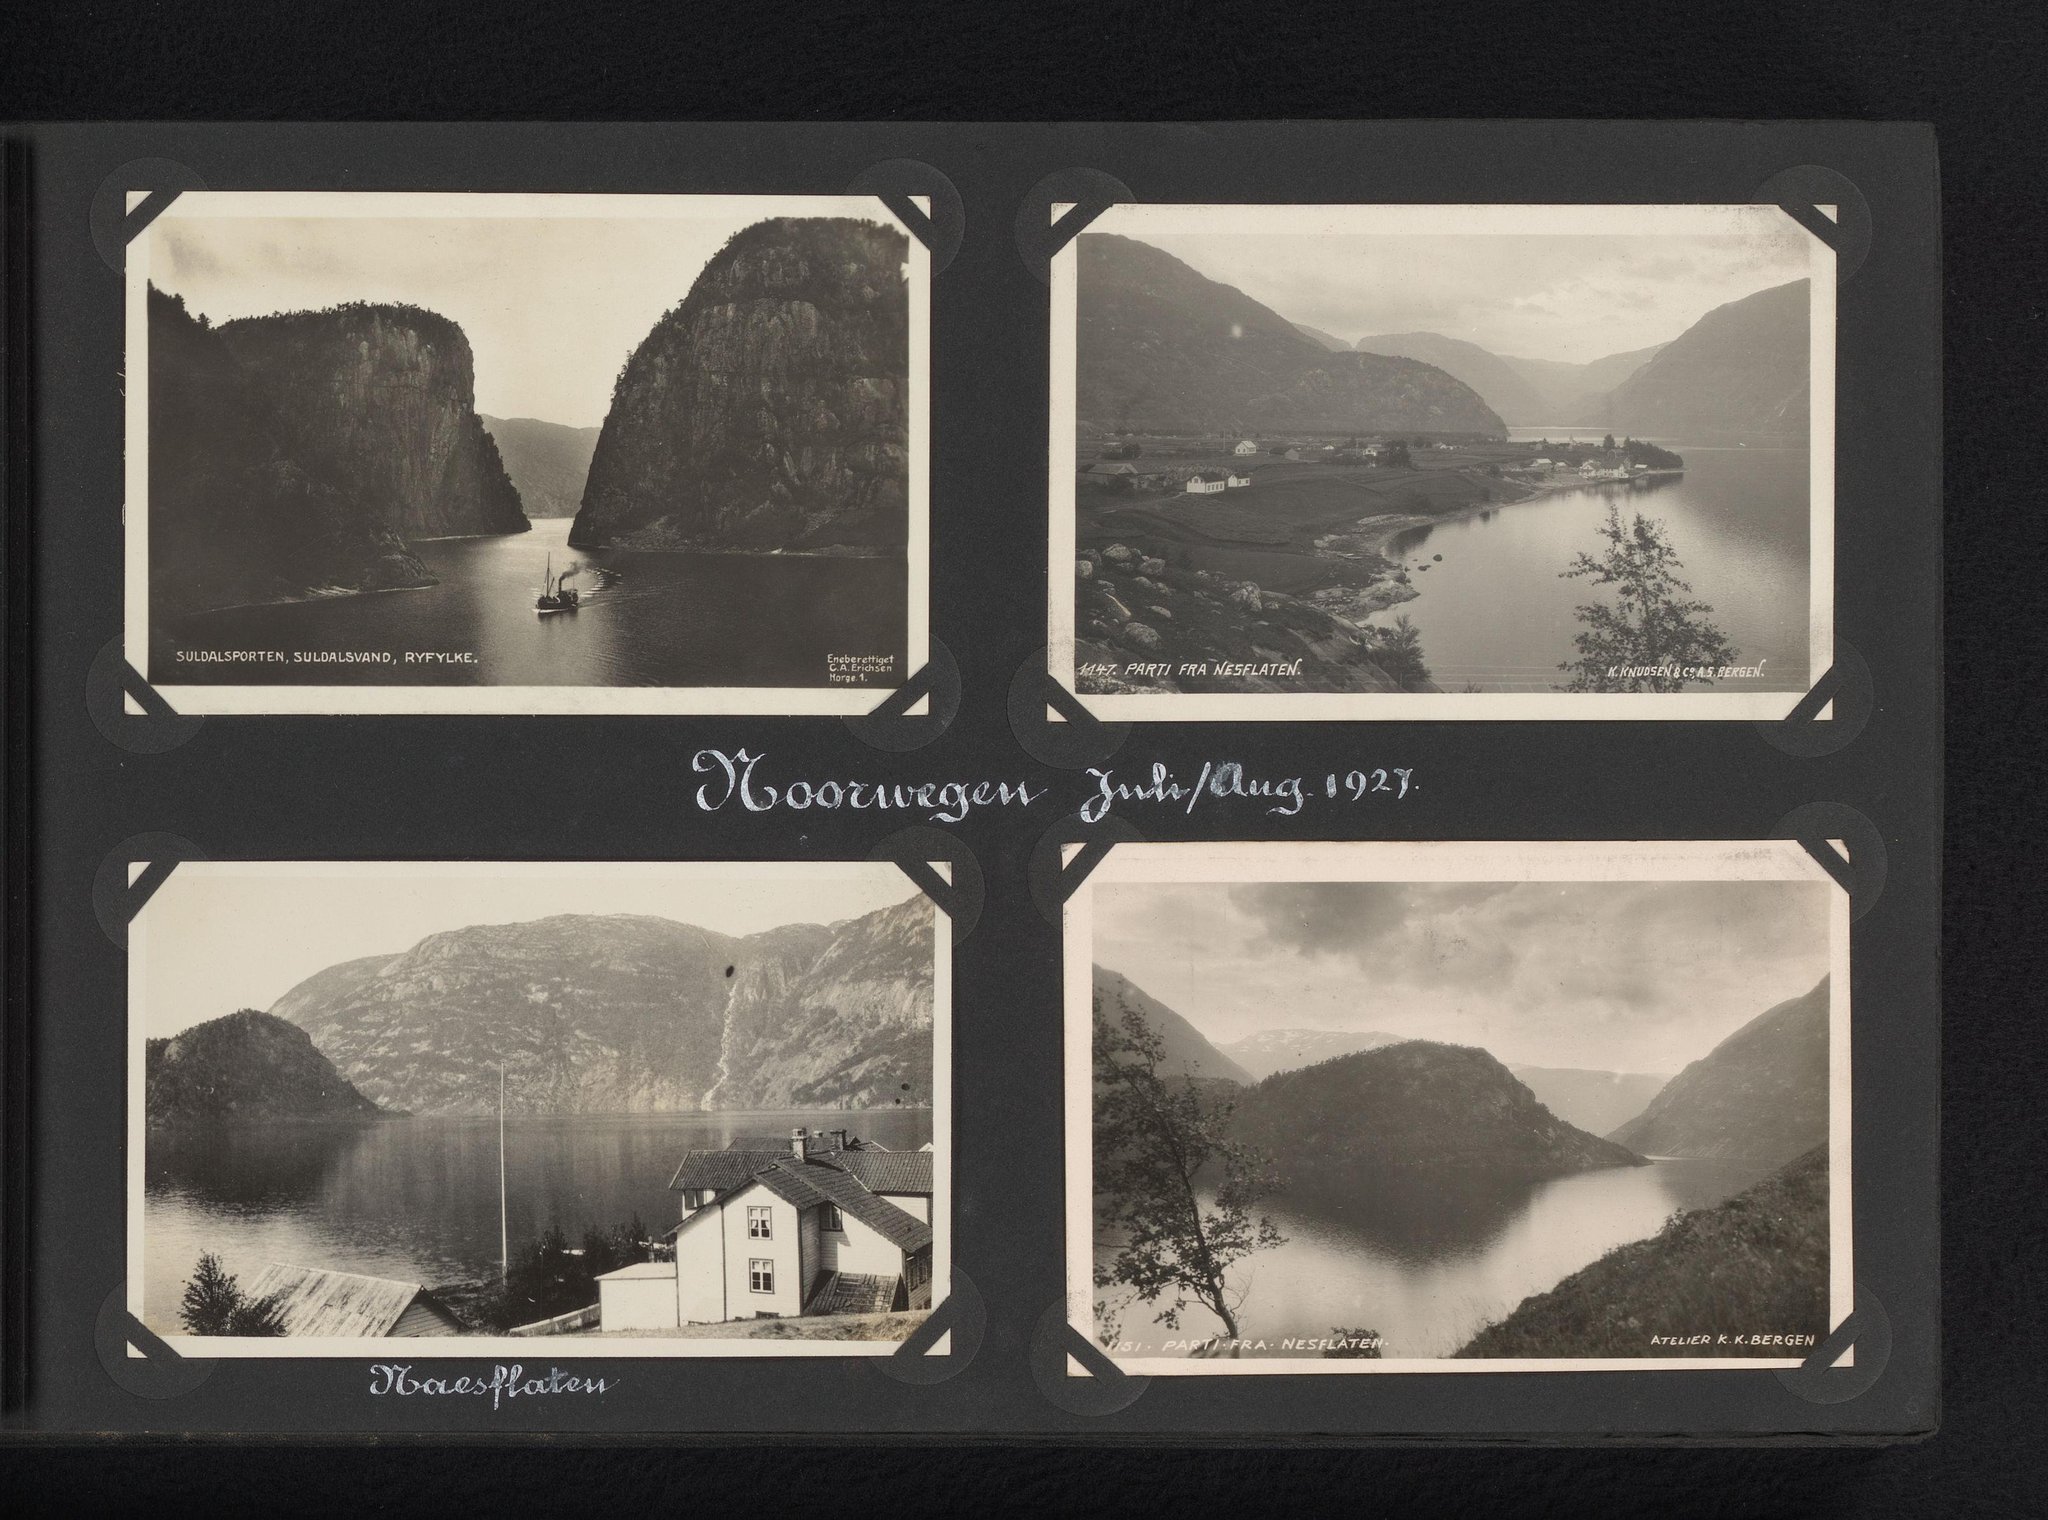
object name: photograph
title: Noorwegen Juli/Aug. 1927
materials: paper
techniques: gelatin silver print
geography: norway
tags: fjord, sea loch, village, steamship, motorship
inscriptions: inscription: ‘Naesflaten’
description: Deze foto's maken deel uit van een album.